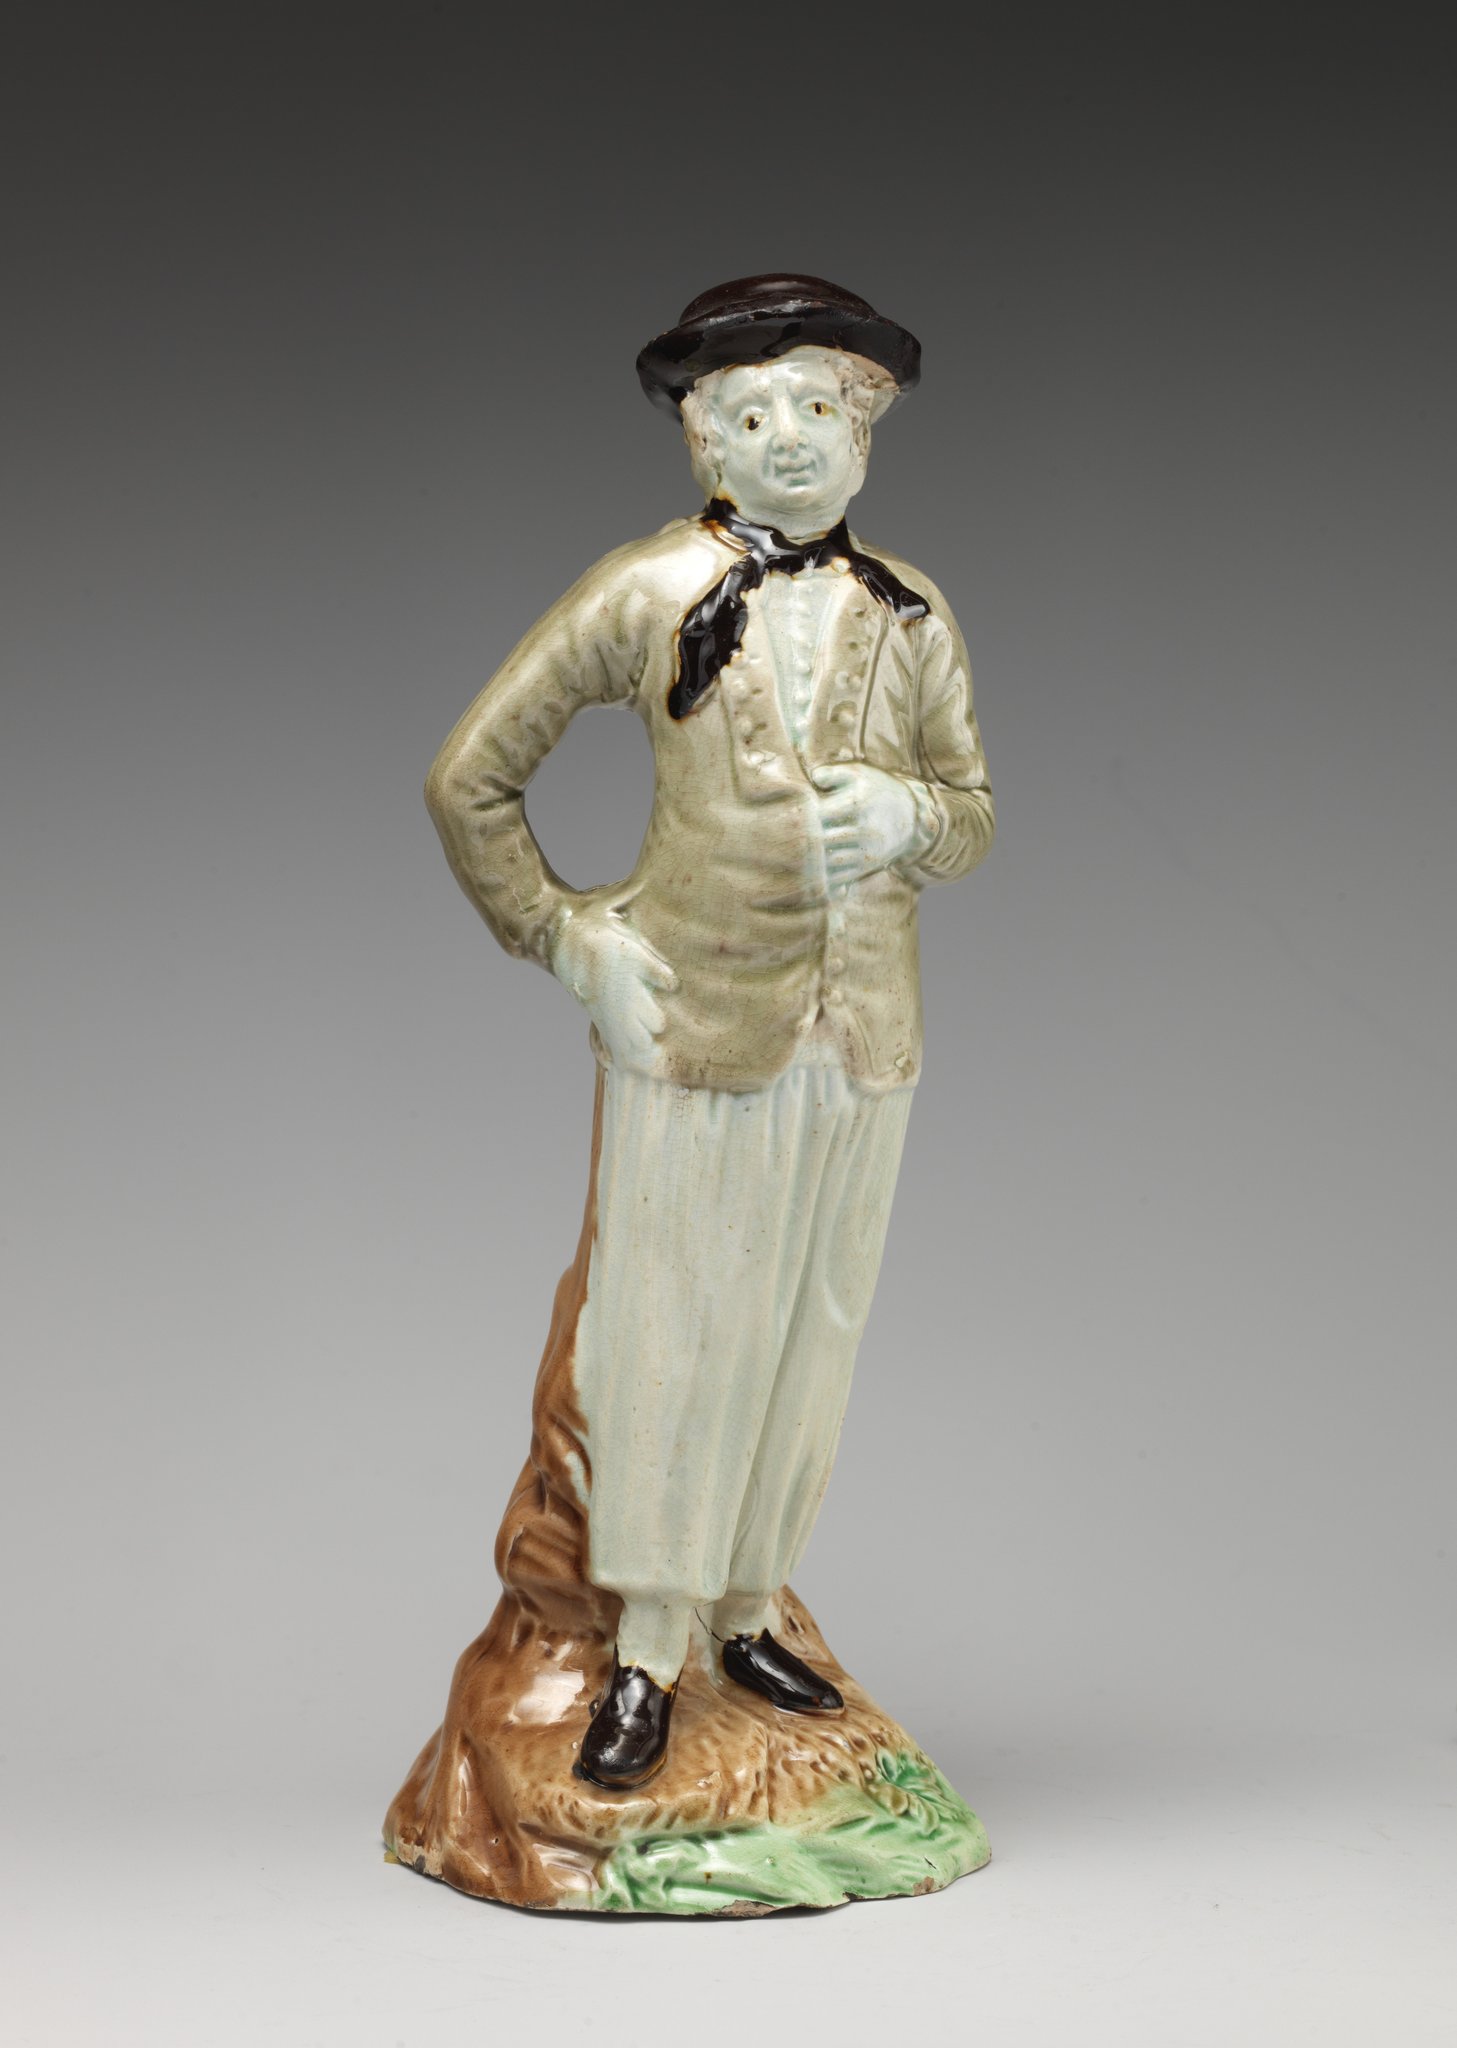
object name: figure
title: Sailor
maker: ralph wood the younger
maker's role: maker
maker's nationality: british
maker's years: 1748-1795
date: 1770-1780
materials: earthenware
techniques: glazing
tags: men,sailors